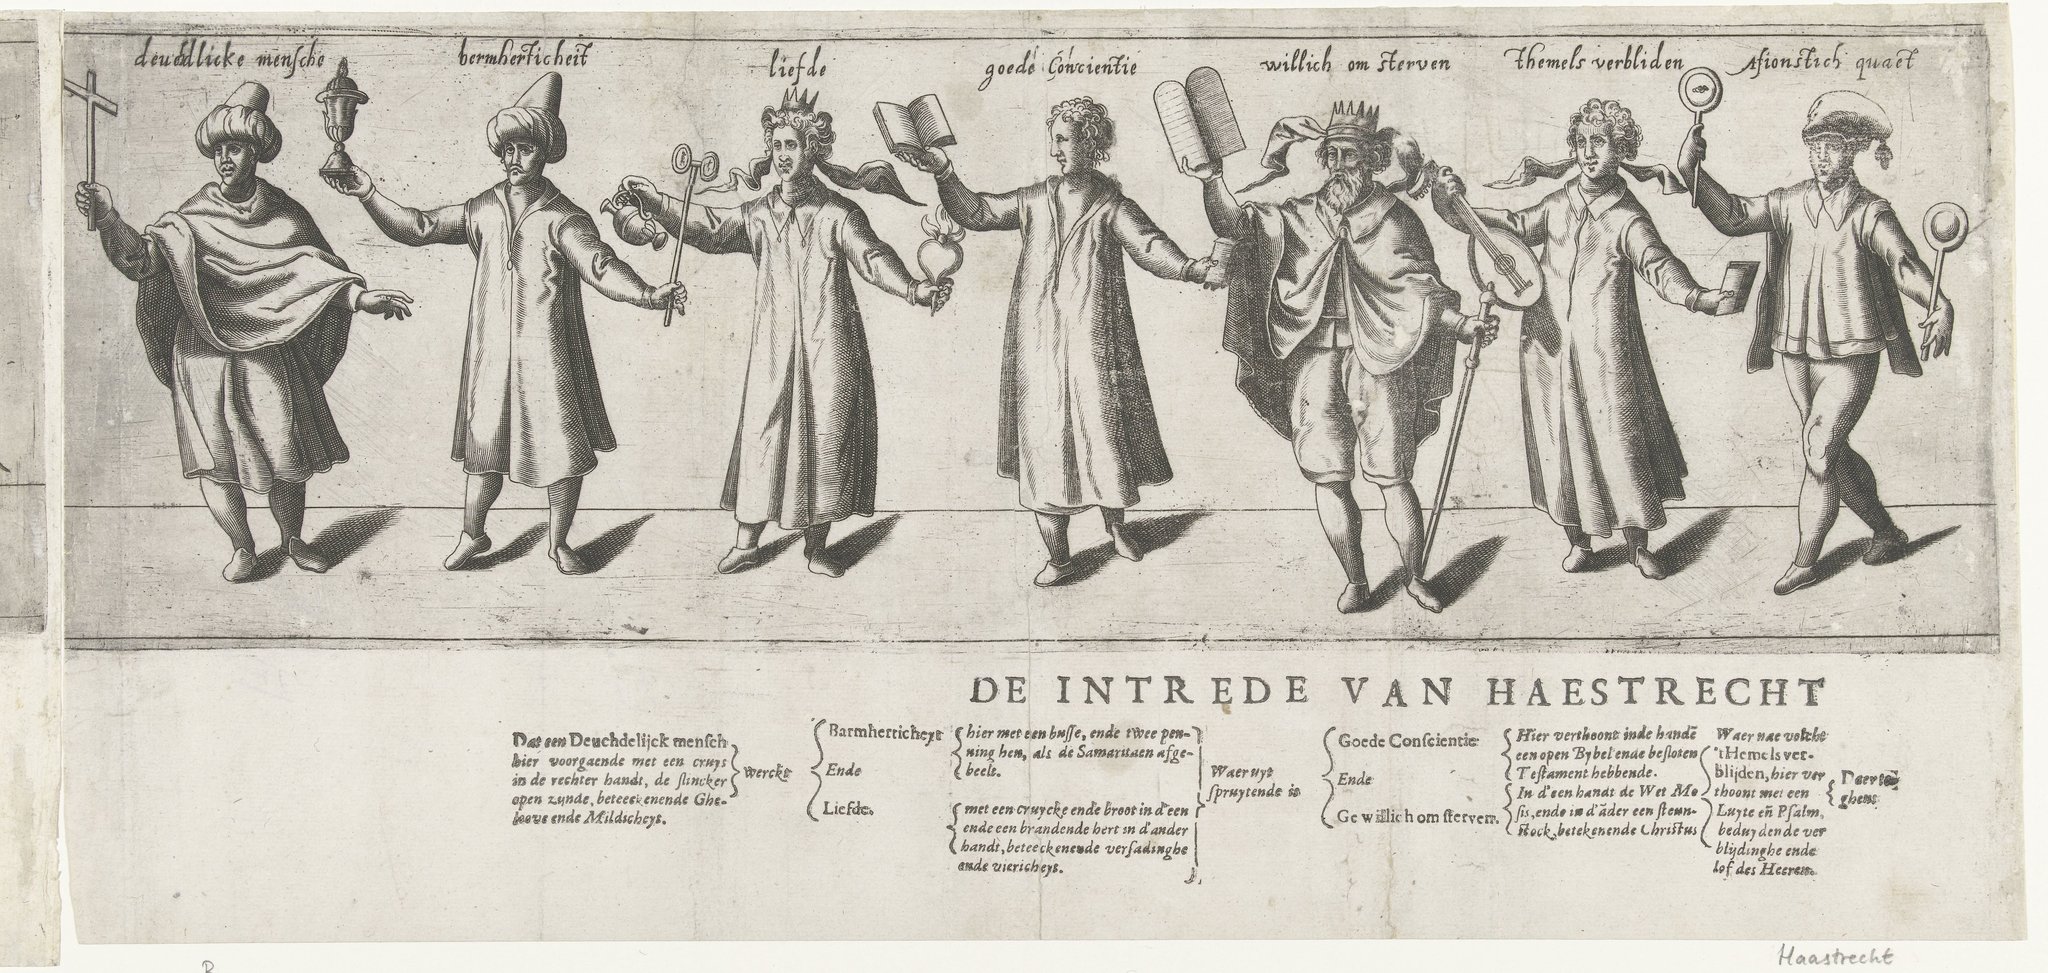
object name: print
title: De intrede van Haestrecht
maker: Anonymous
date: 1607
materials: paper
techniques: engraving, letterpress printing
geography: northern netherlands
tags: chamber of rhetoric (dutch: 'rederijkerskamer'), festivities (+ parade, pageant, cavalcade ~ festive activities), haarlem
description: Gebruikt als illustratie in: Const-thoonende ivweel, by de loflijcke stadt Haerlem, ten versoecke van Trou moet blijcken, in't licht gebracht. : Waer inne duydelick verclaert ende verthoont wordt alles wat den mensche mach wecken om den armen te troosten, ende zijnen naesten by te staen. : In twaelf spelen van sinne ... in redenrijck naar de volgende voorgegevene caerte van 't speel-korenken, Zacharias Heyns, Zwolle 1607. Los fragment, bedoeld om samen met de andere delen tot een fries gemonteerd te worden.